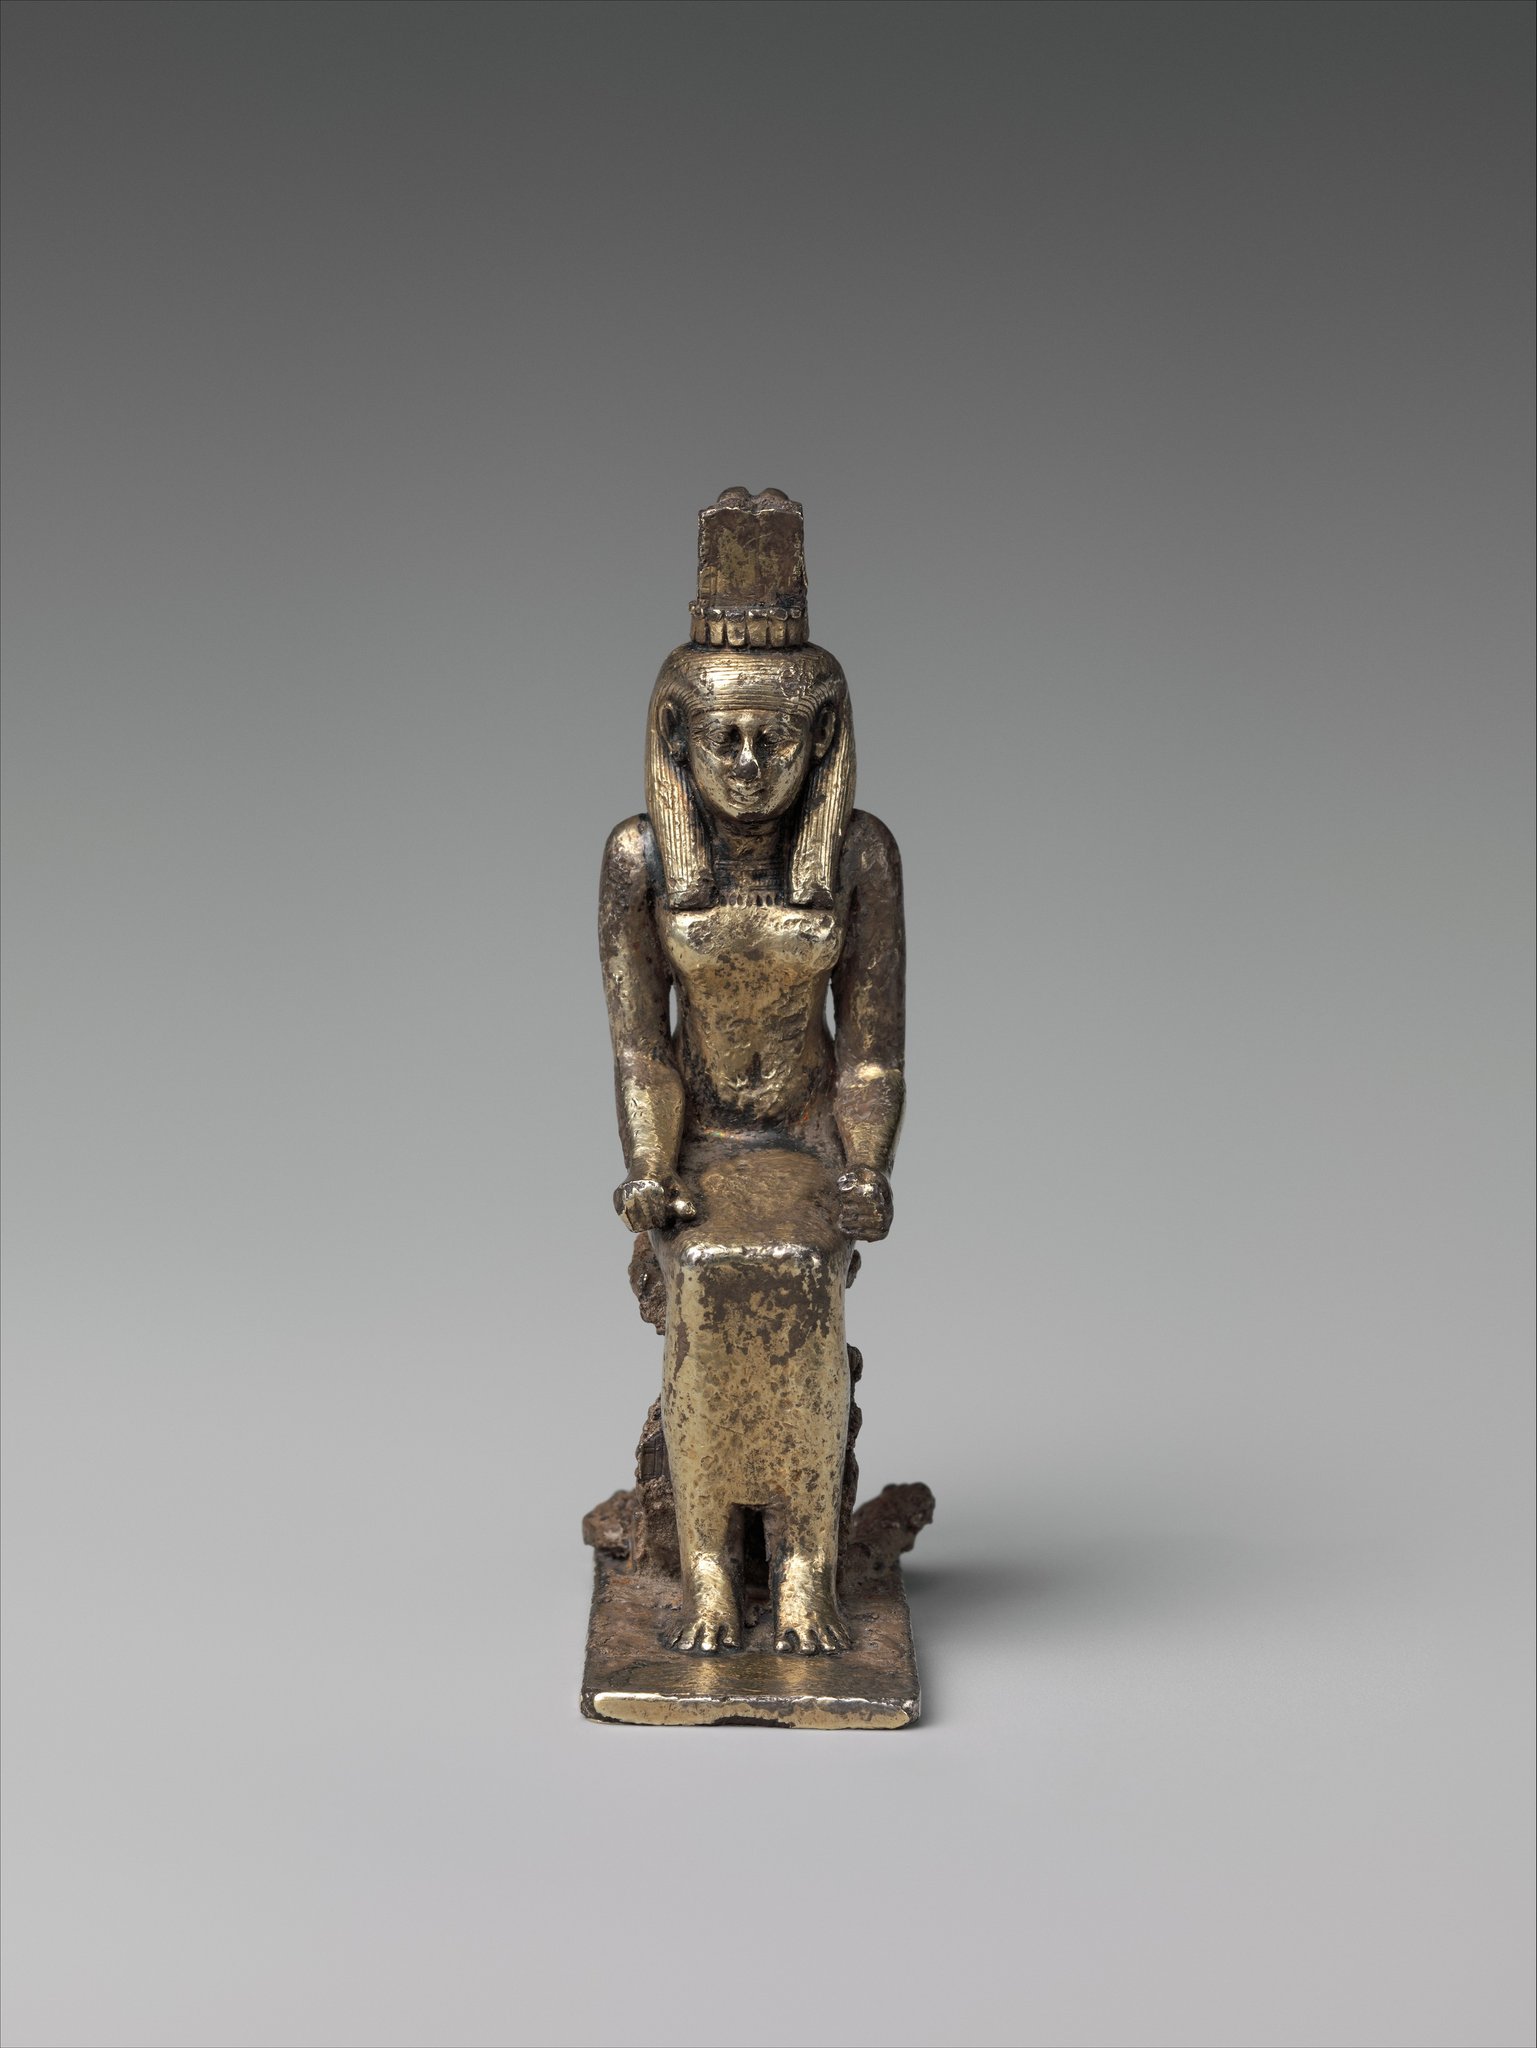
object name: nephthys, inscribed for mereskhonsu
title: Seated goddess Nephthys, inscribed for Mereskhonsu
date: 715-650 BCE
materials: silver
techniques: gilding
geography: egypt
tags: goddess